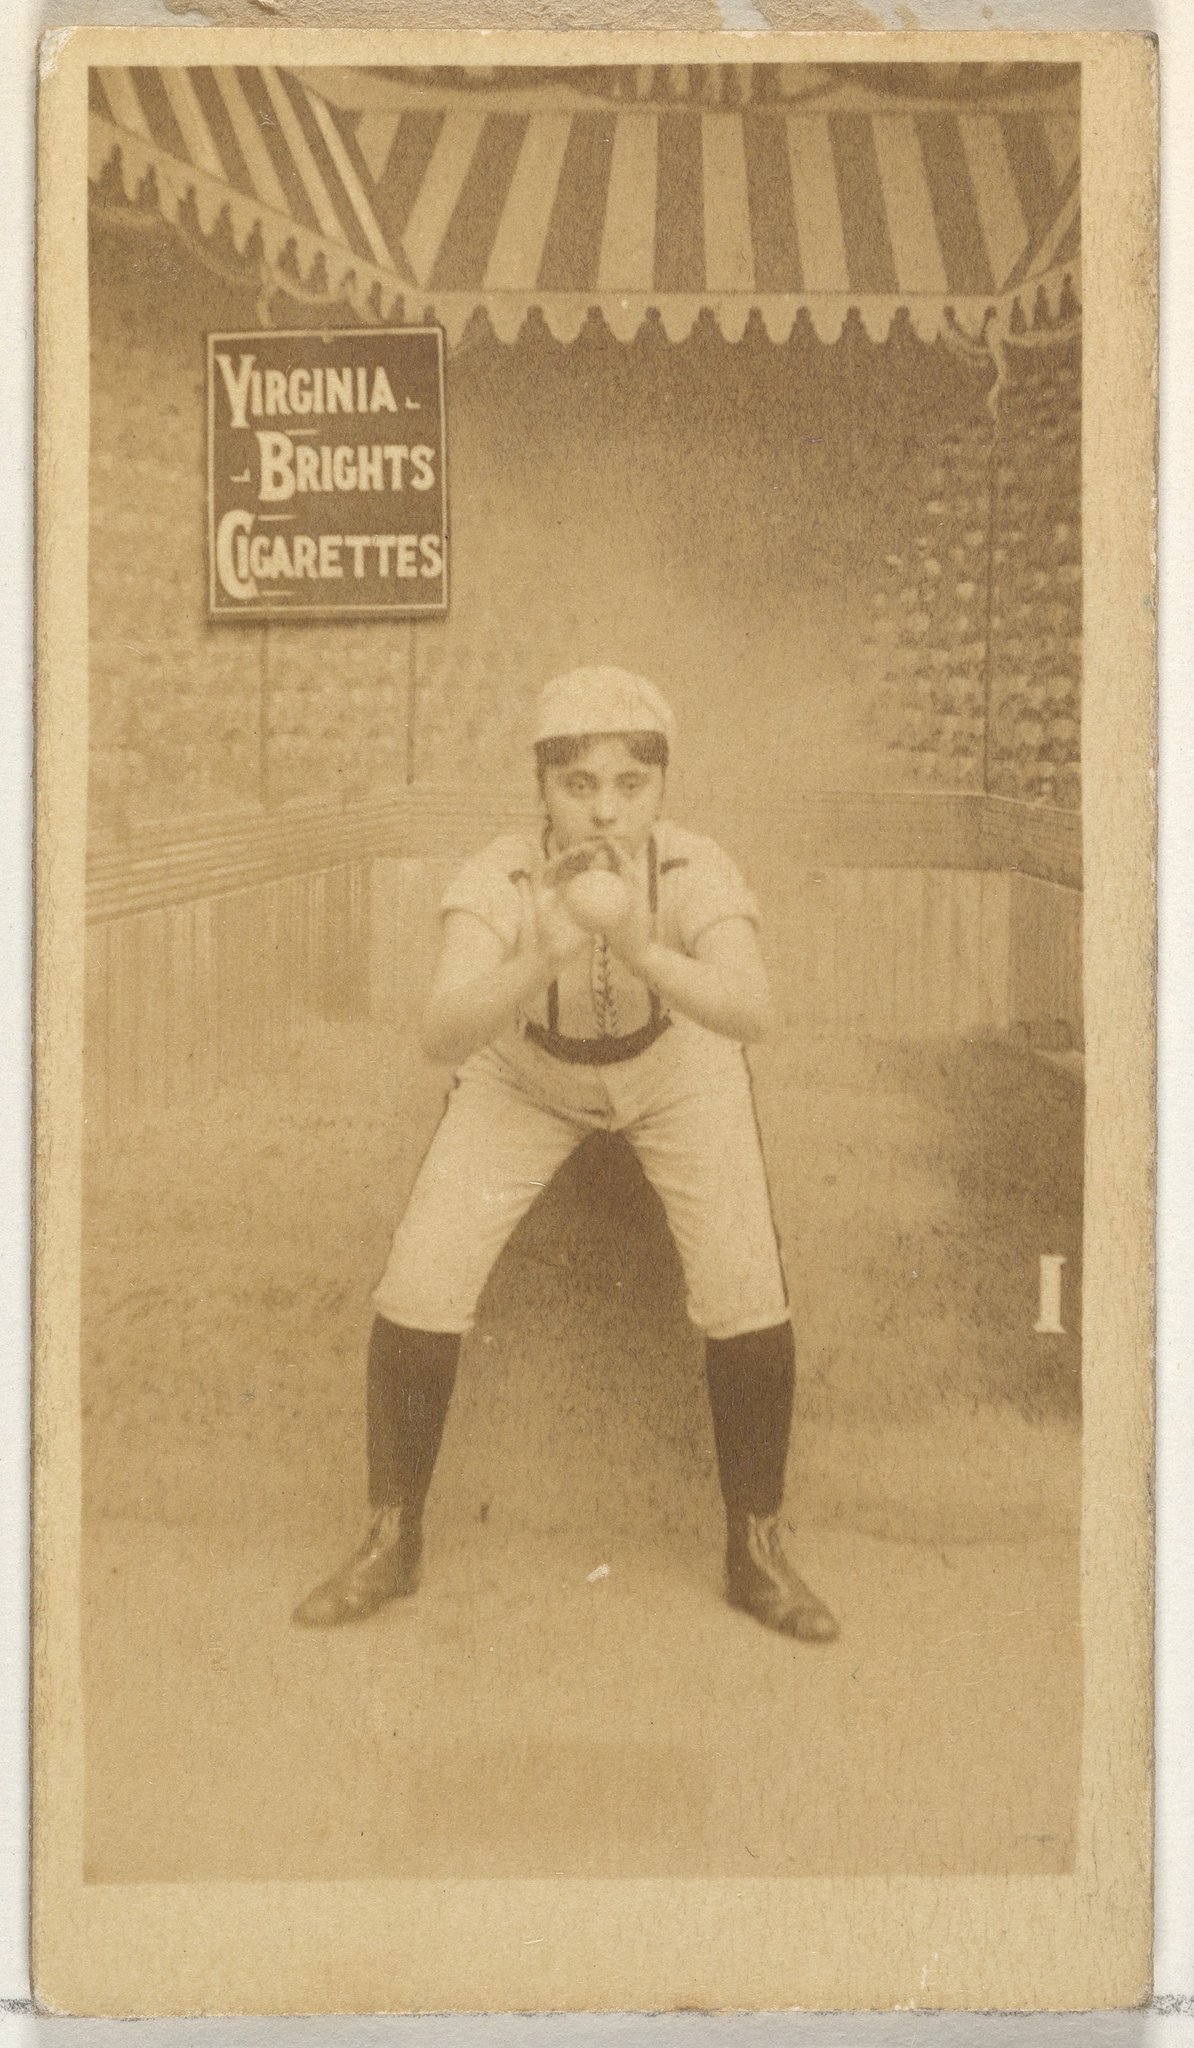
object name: baseball card, photograph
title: Card 1, from the Girl Baseball Players series (N48, Type 2) for Virginia Brights Cigarettes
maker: allen & ginter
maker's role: publisher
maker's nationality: american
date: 1886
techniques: albumen silver print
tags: portraits,women,baseball,athletes